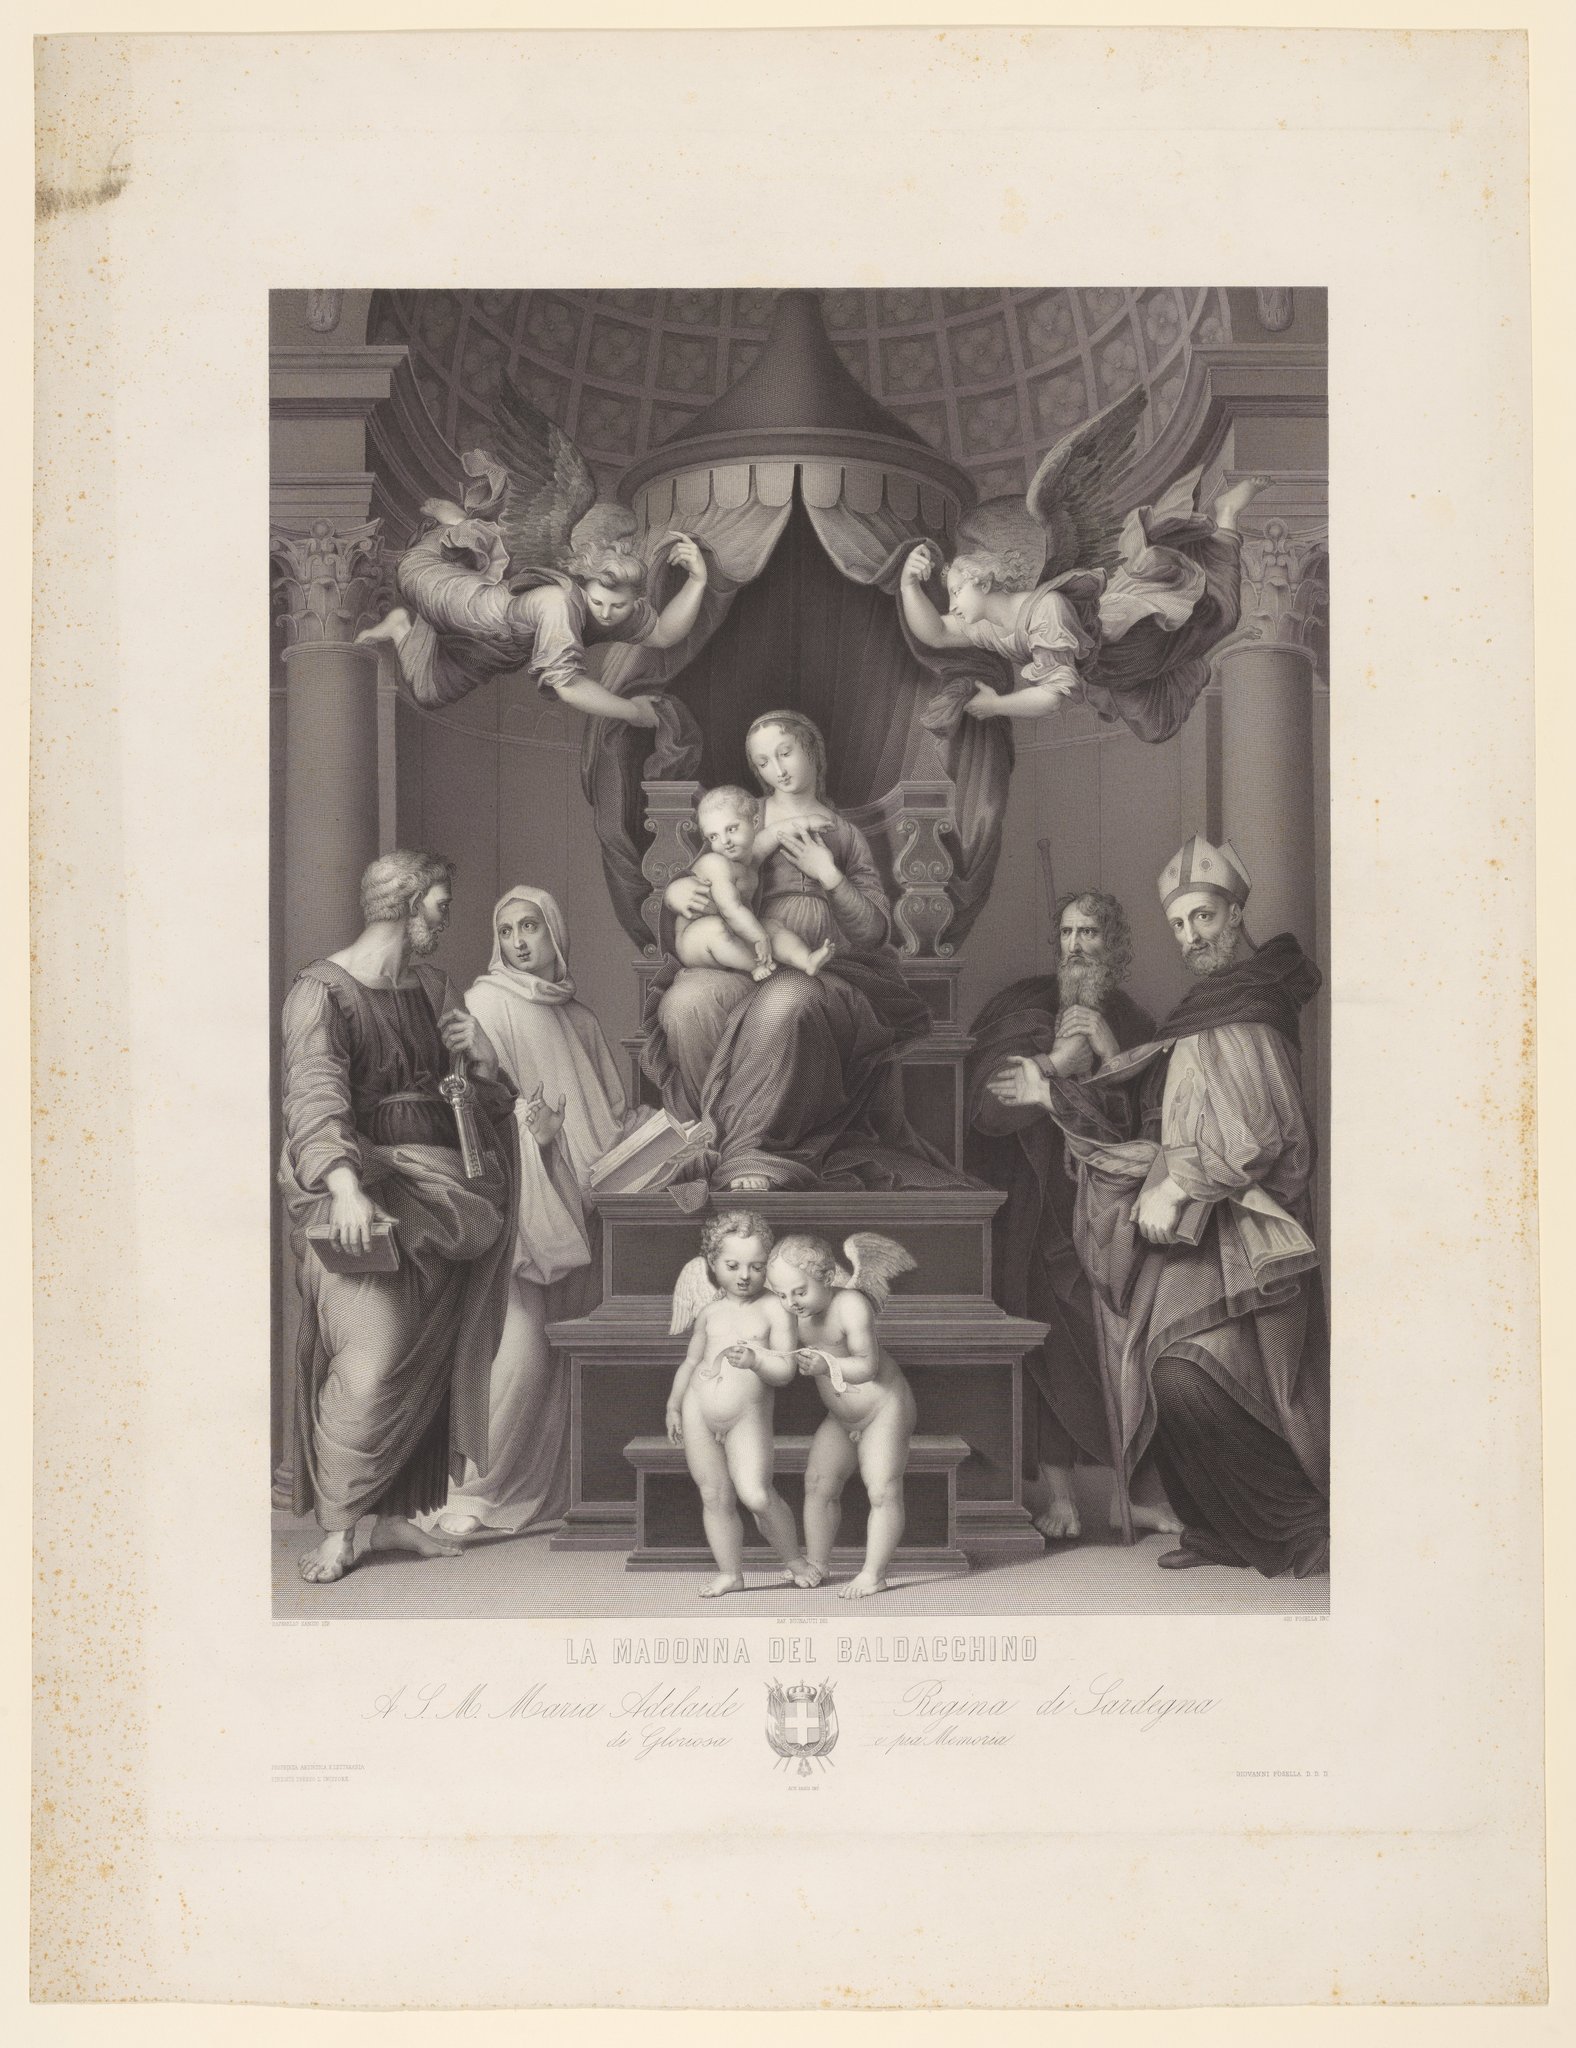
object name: print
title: The Madonna and Child enthroned, surrounded by Saints Bernard, Peter, James and Augustine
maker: giovanni fosella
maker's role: artist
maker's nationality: italian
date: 1860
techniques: engraving